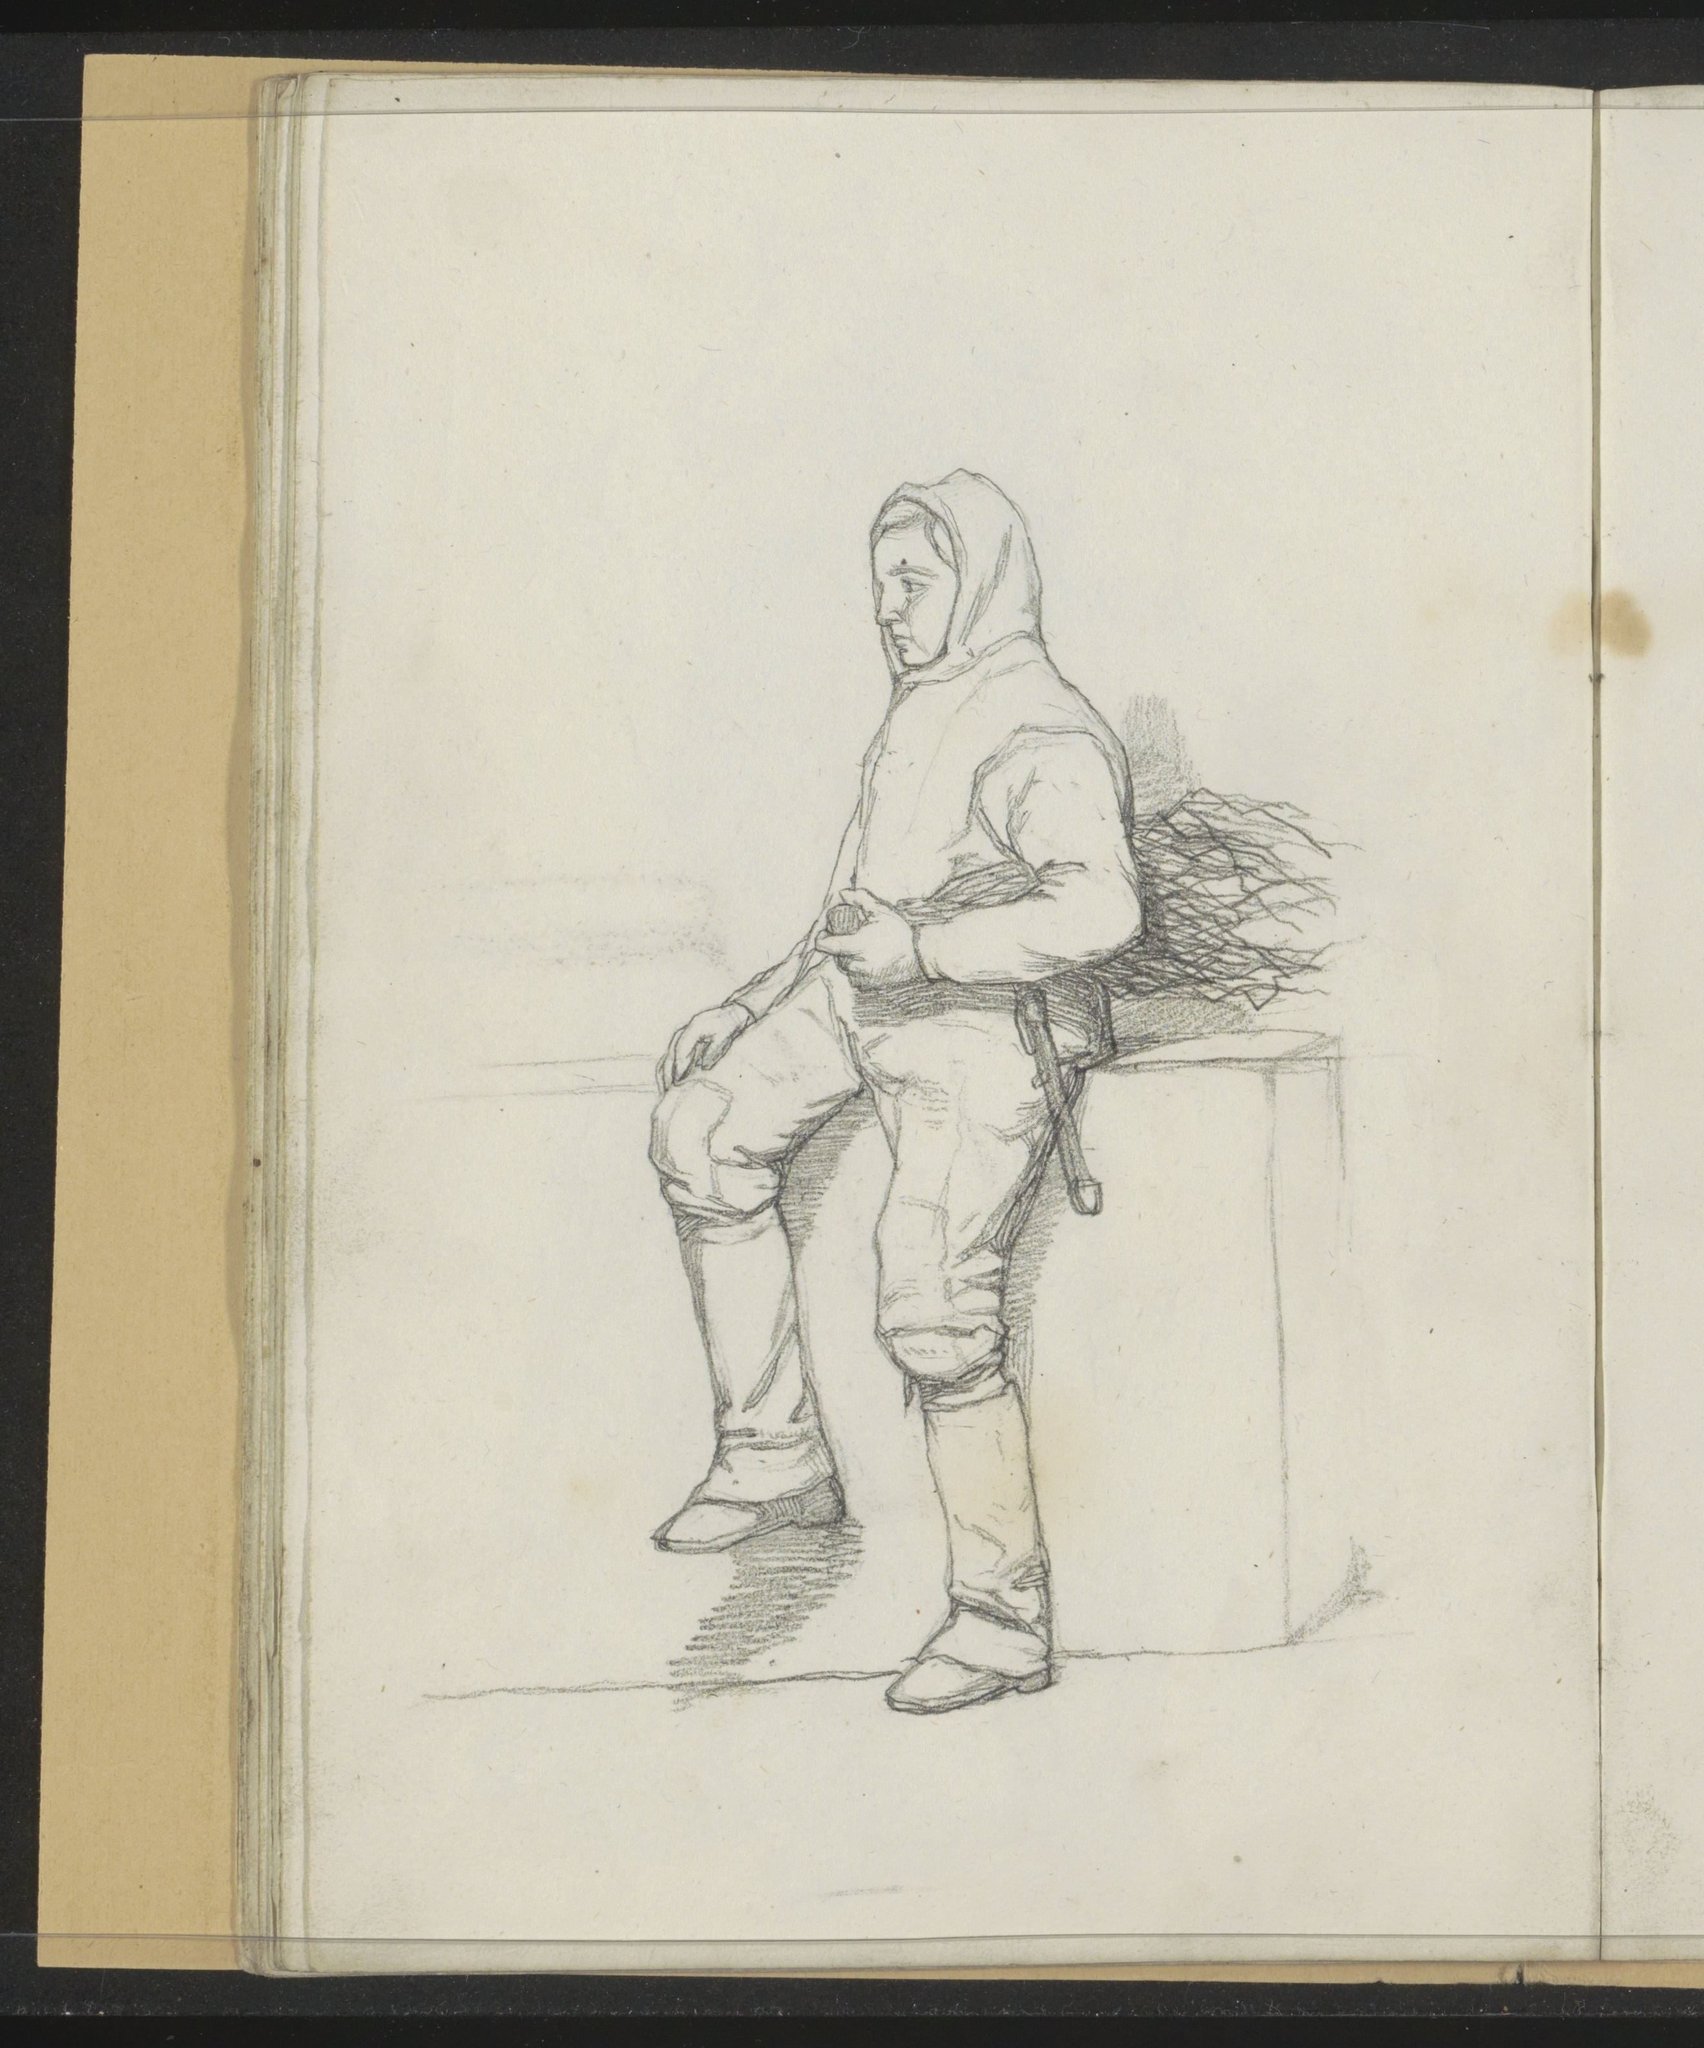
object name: sketchbook leaf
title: Zittende jongen met een takkenbos onder de arm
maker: jozef israëls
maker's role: draughtsman, painter, print maker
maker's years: 1824-1911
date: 1834-1911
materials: paper, pencil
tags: trees (+ bundle of twigs, faggot), head-gear: hood (+ men's clothes), sitting figure (+ young male (human being))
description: De jongen draagt laarzen en een pak met een capuchon. Blad 14 verso uit een schetsboek met 16 bladen.